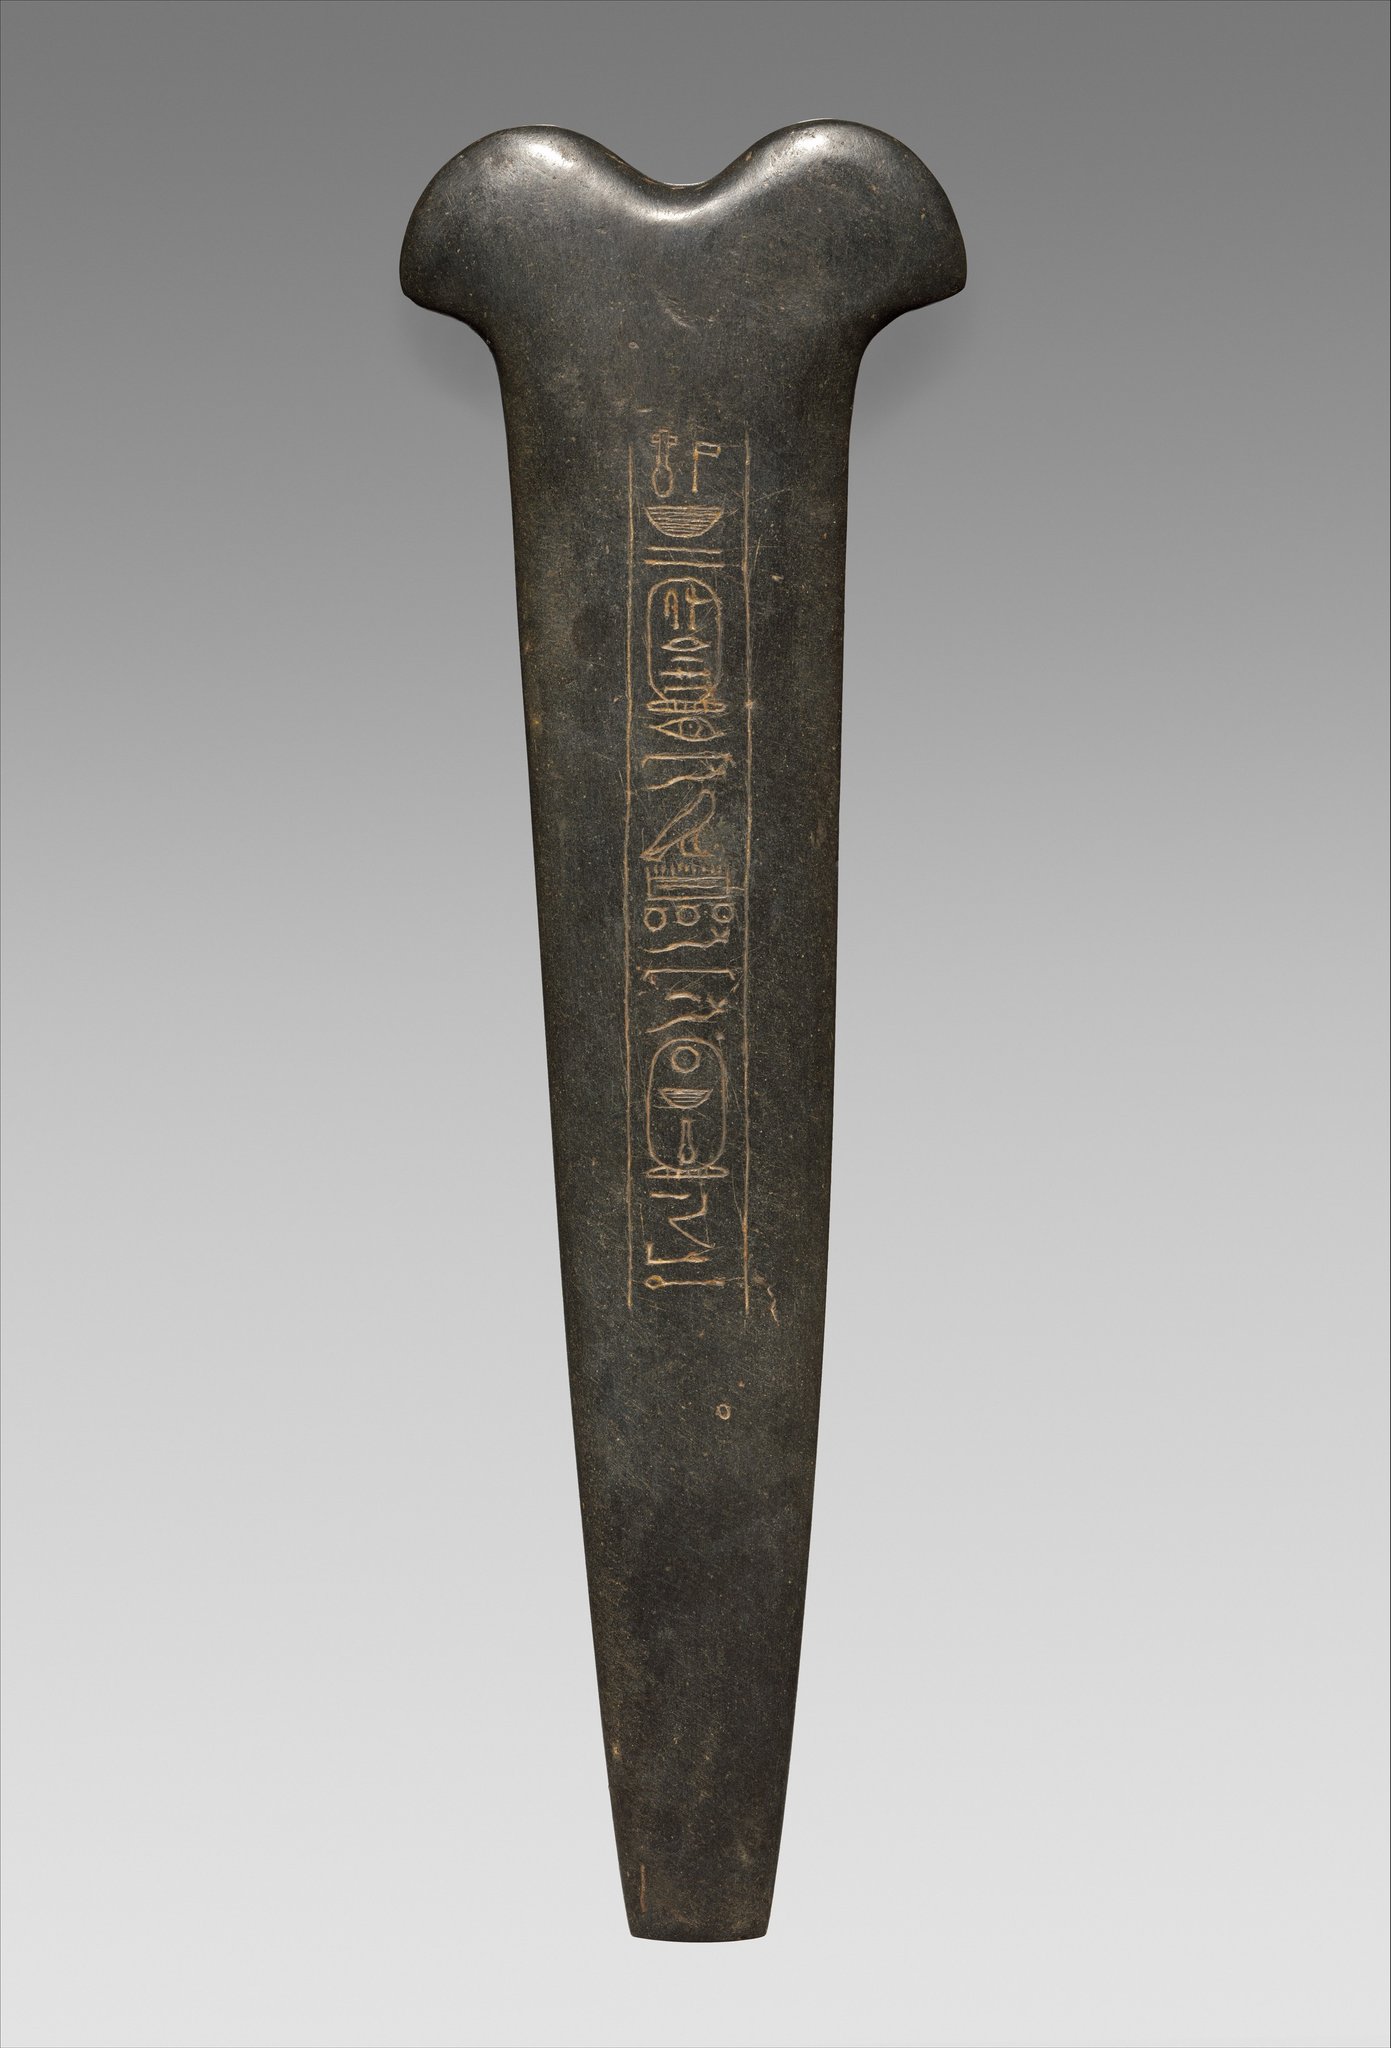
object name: tool, opening of the mouth, peseshkef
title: Ritual Implement Dedicated by a King Senwosret to Nebhepetre Mentuhotep II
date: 1961-1840 BCE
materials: granite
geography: egypt